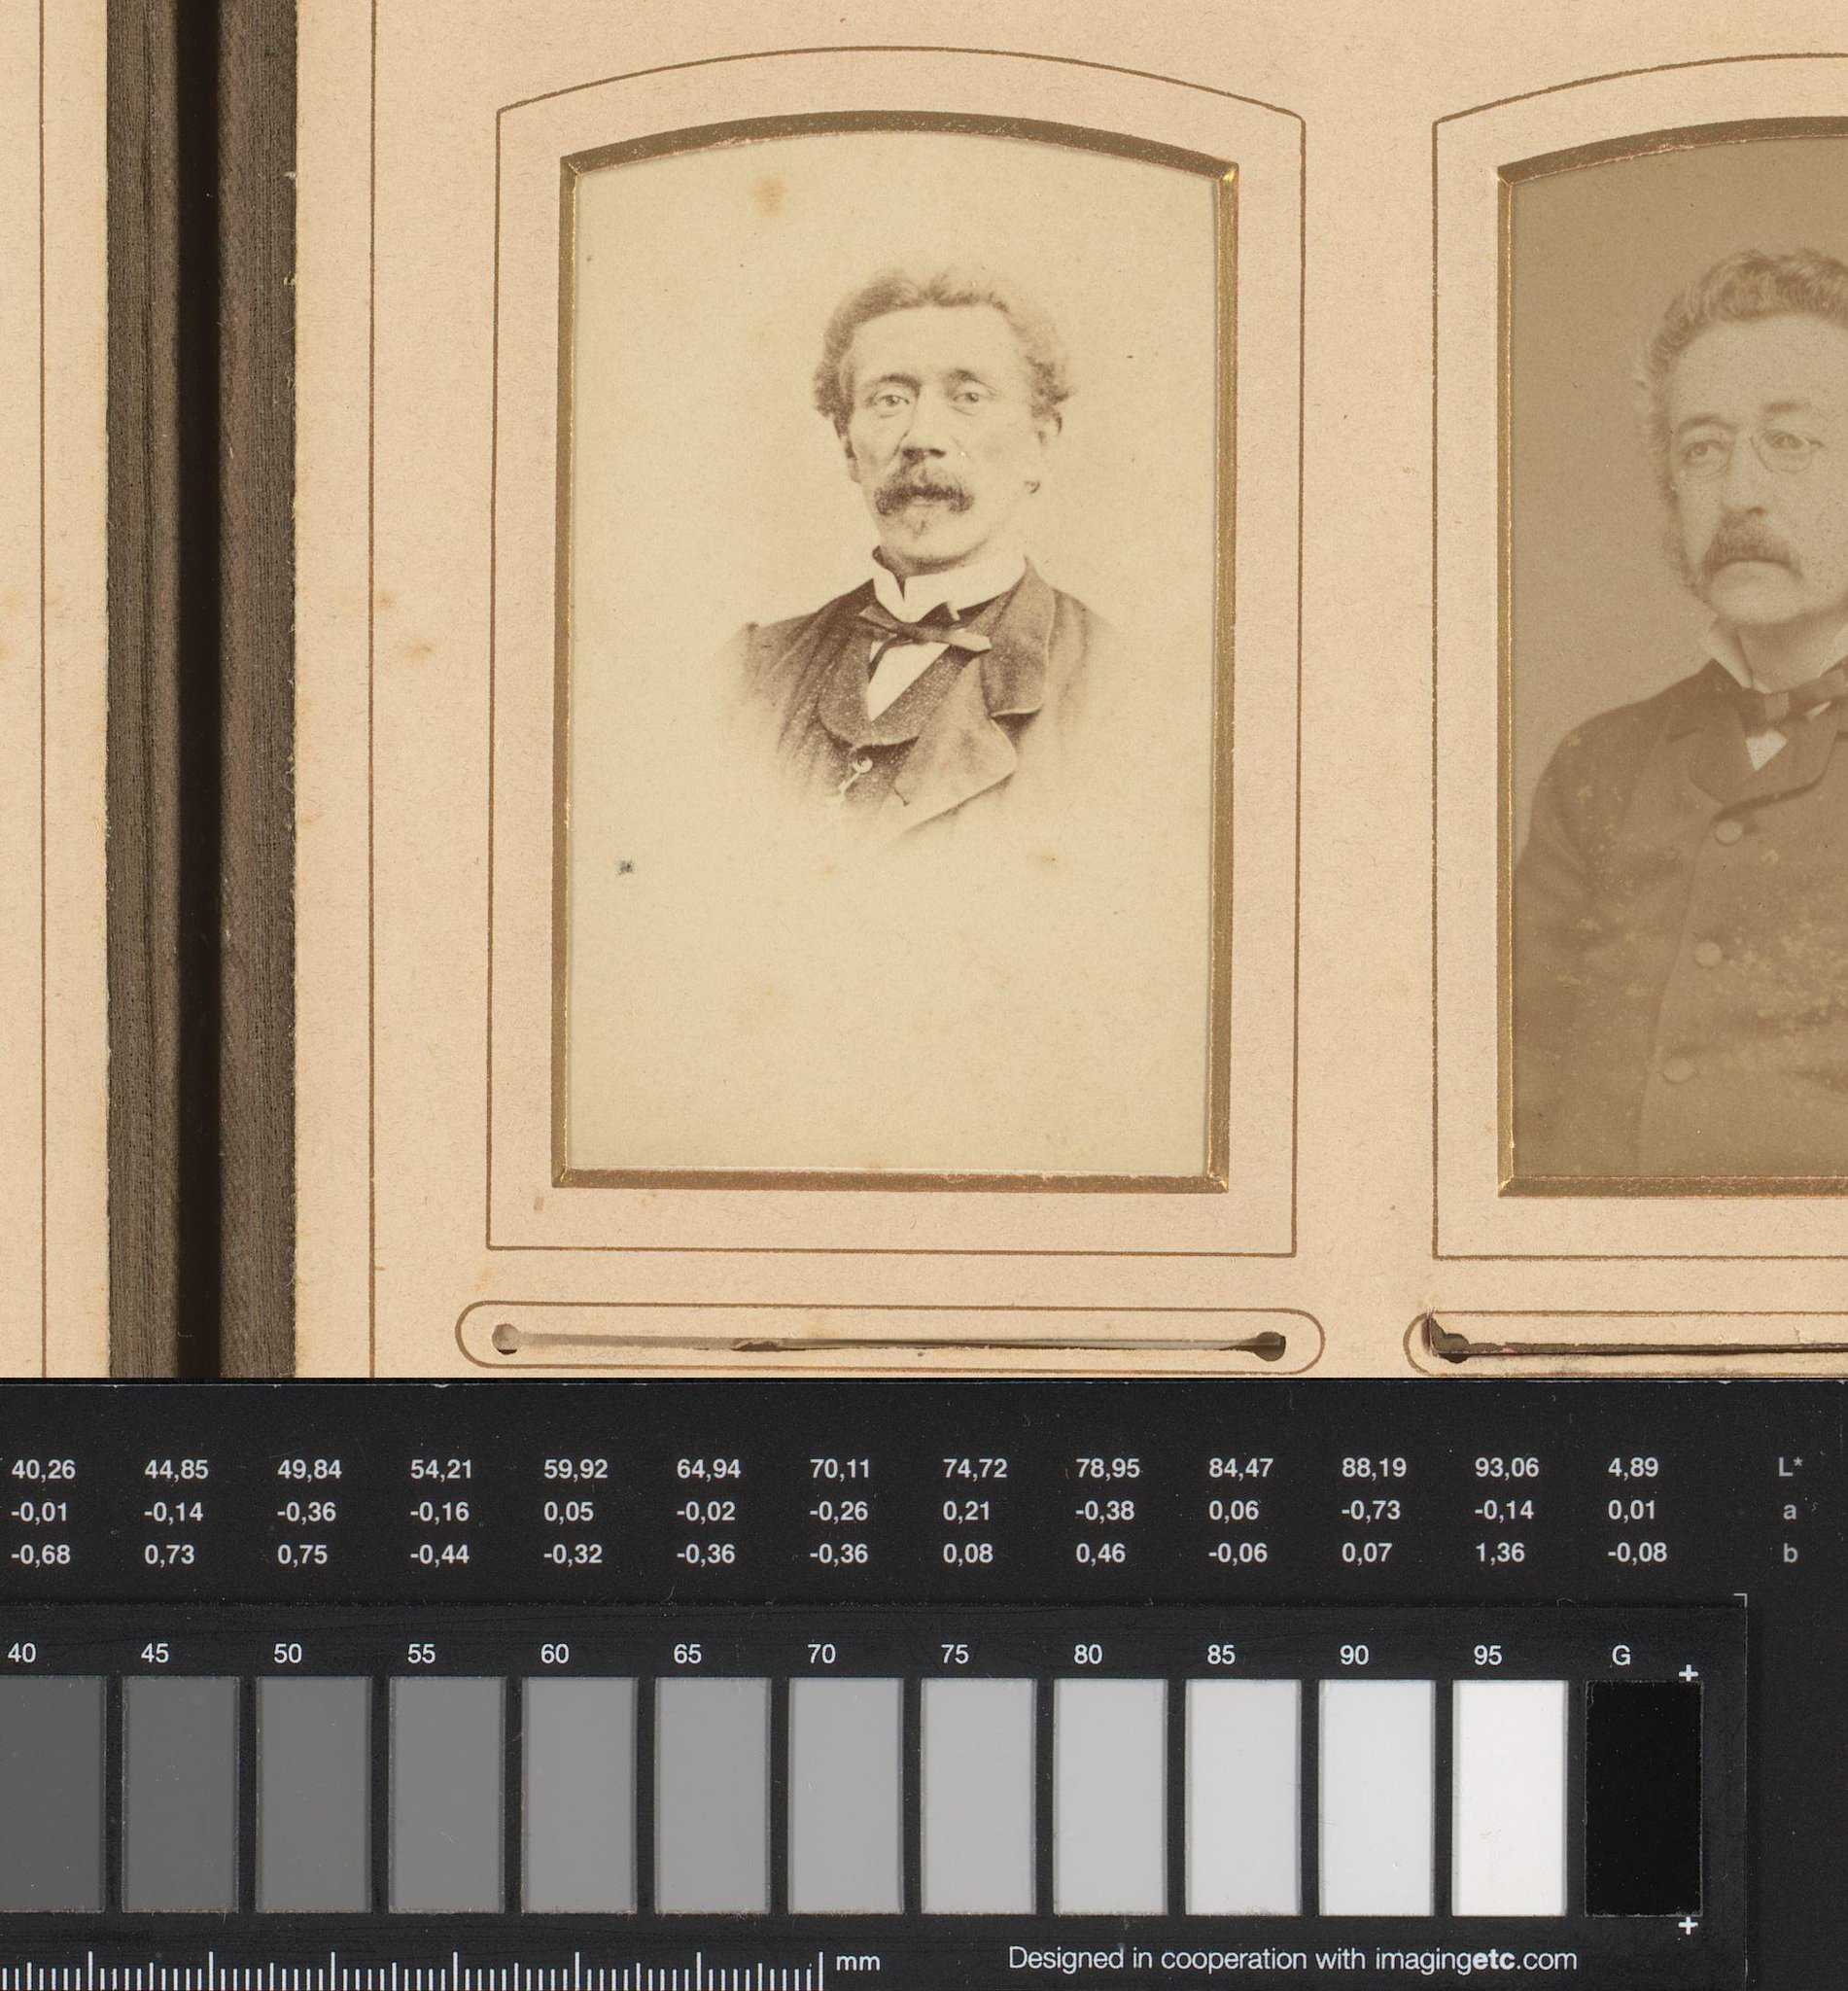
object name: carte de visite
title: Portret van een onbekende man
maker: albert greiner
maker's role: fotograaf, fotostudio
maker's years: 1833-1890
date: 1870-1874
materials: cardboard, paper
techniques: albumen print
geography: amsterdam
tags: anonymous historical person portrayed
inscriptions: address: ‘NIEUWENDIJK L. 87/ AMSTERDAM’